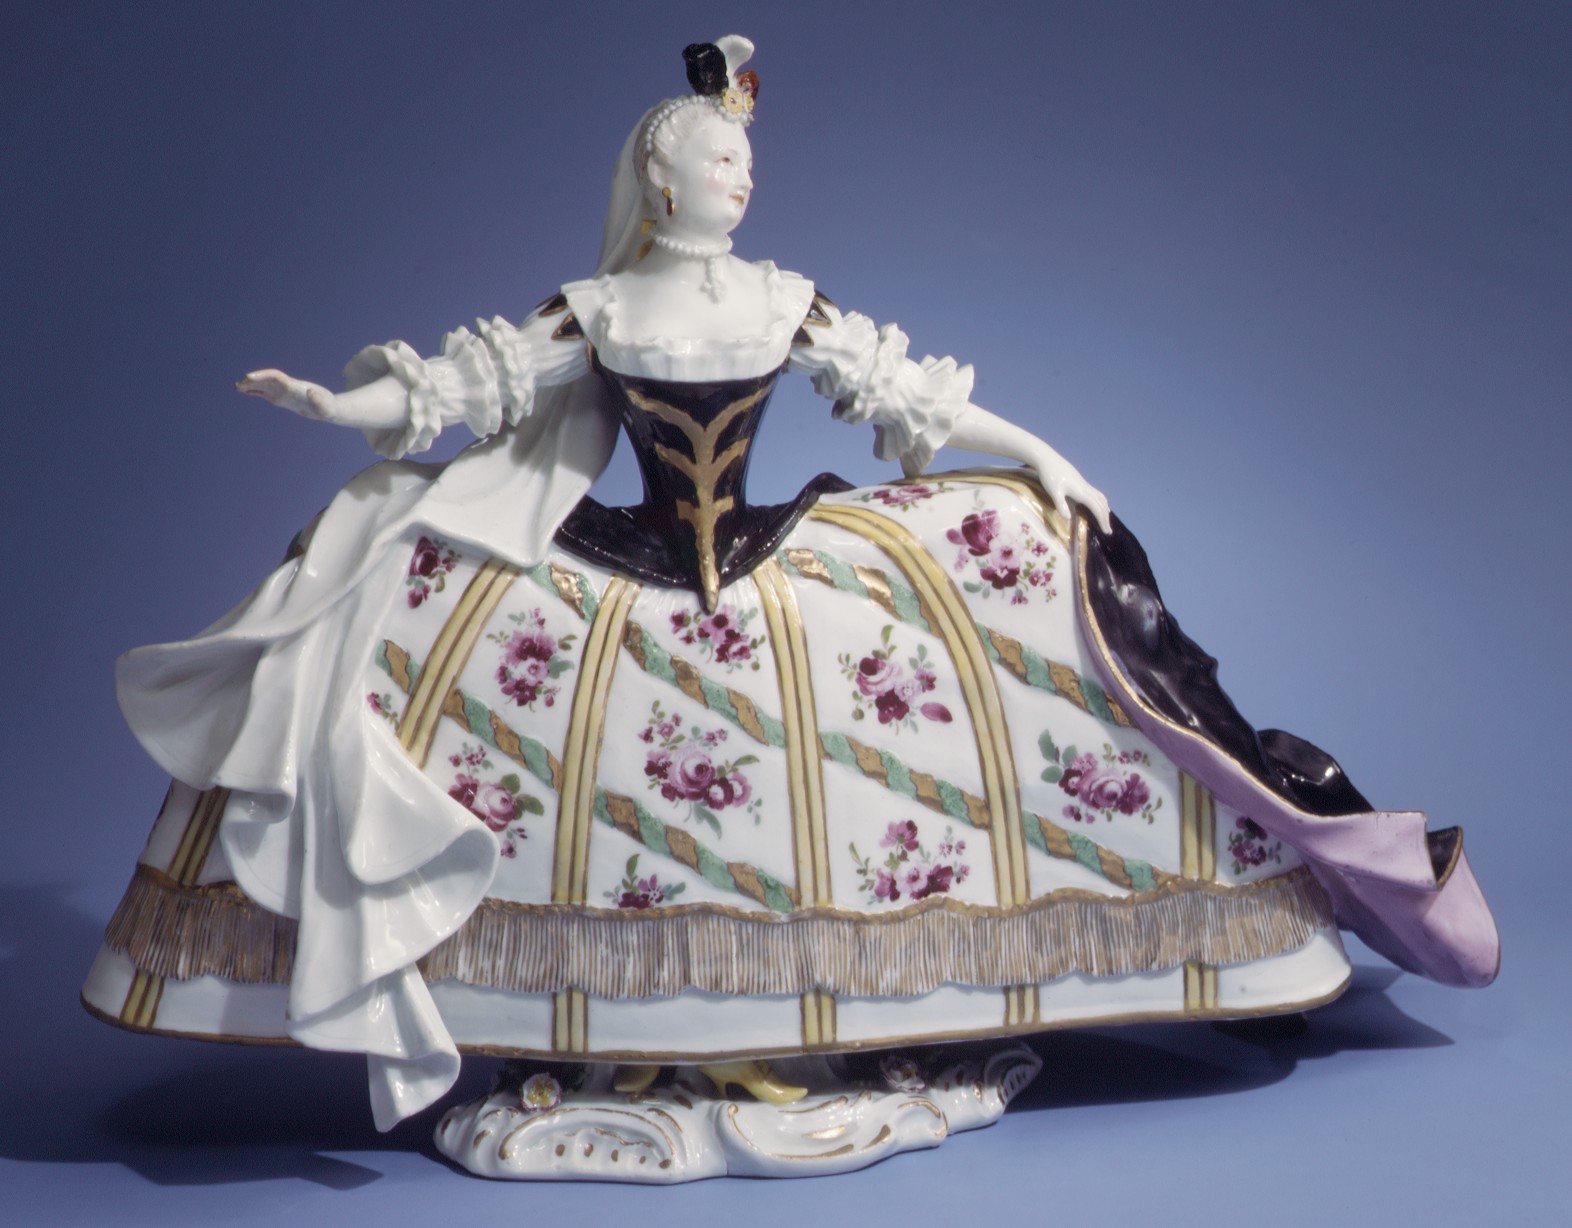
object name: figure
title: Theater figure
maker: meissen manufactory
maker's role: manufactory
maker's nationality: german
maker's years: 1710-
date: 1750-1752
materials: hard paste porcelain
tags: women